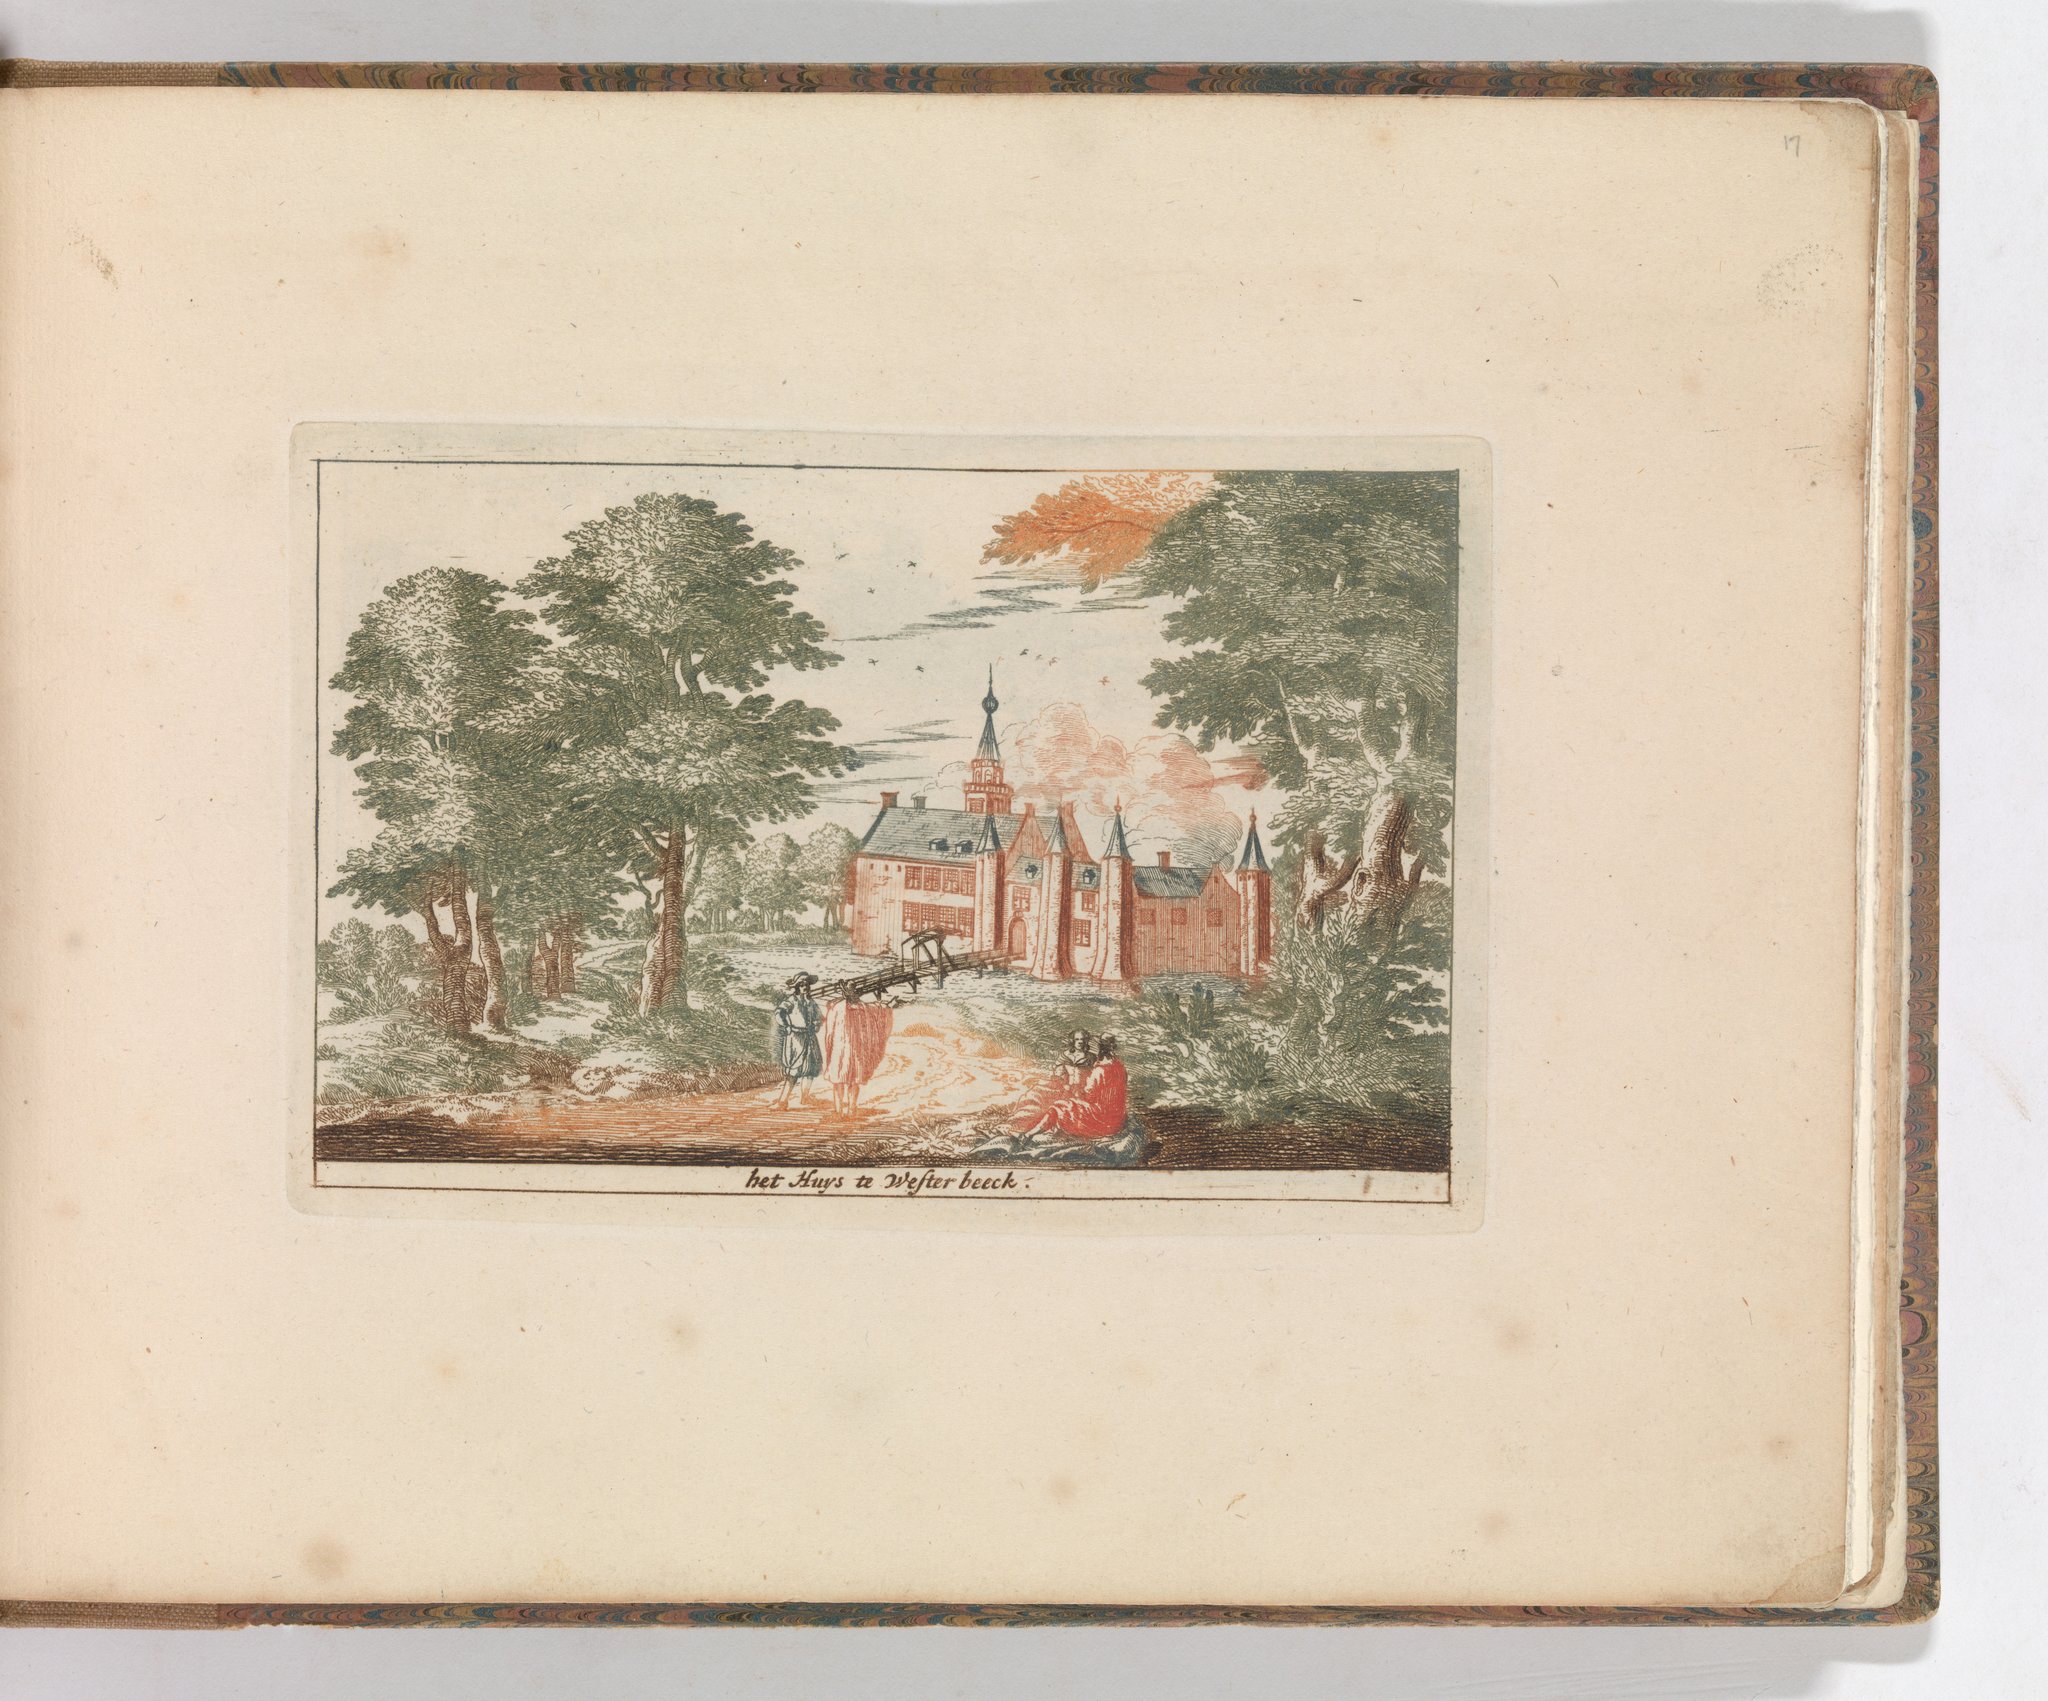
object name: book print ornament architecture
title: 'Het Huys te Westerbeeck' , in: Tooneel Der Voornaamste Nederlands Huizen, En Lust Hoven, Naar T Leven Afgebeeld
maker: carel allard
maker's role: publisher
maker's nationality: dutch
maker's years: 1648-1709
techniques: engraving, lithography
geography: amsterdam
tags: human figures,palaces